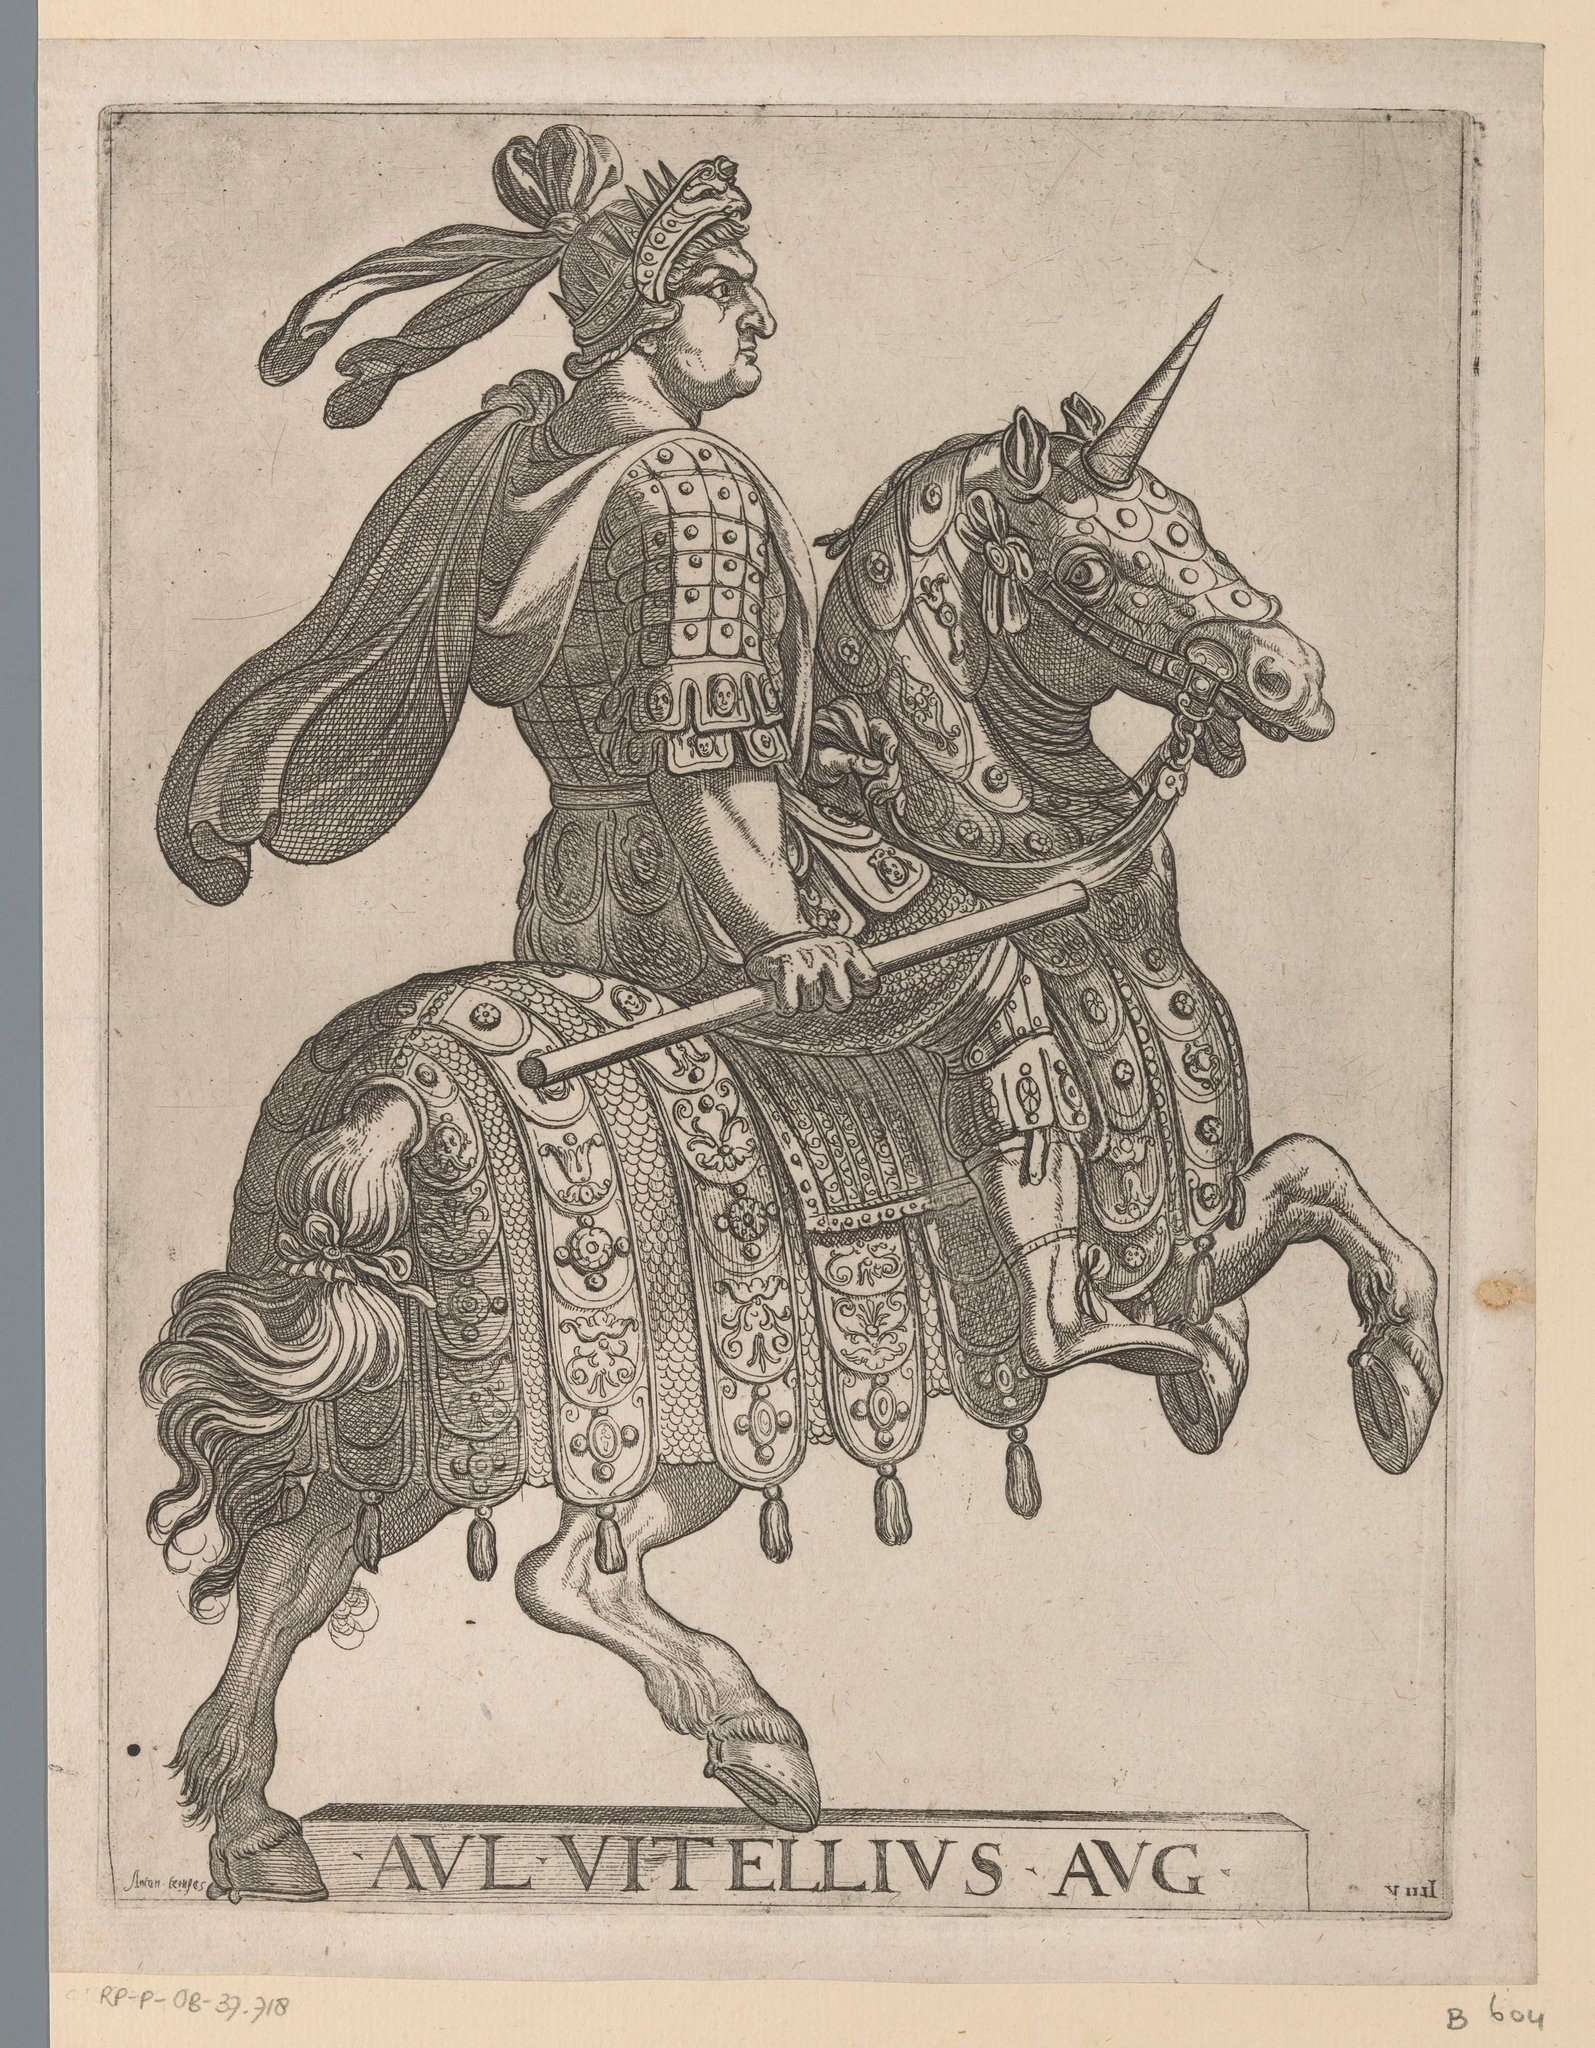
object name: print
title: Keizer Vitellius te paard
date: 1596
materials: paper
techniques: etching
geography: italy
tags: rome, emperor, equestrian statue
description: Titelprent bij een reeks van twaalf prenten van Romeinse keizers.